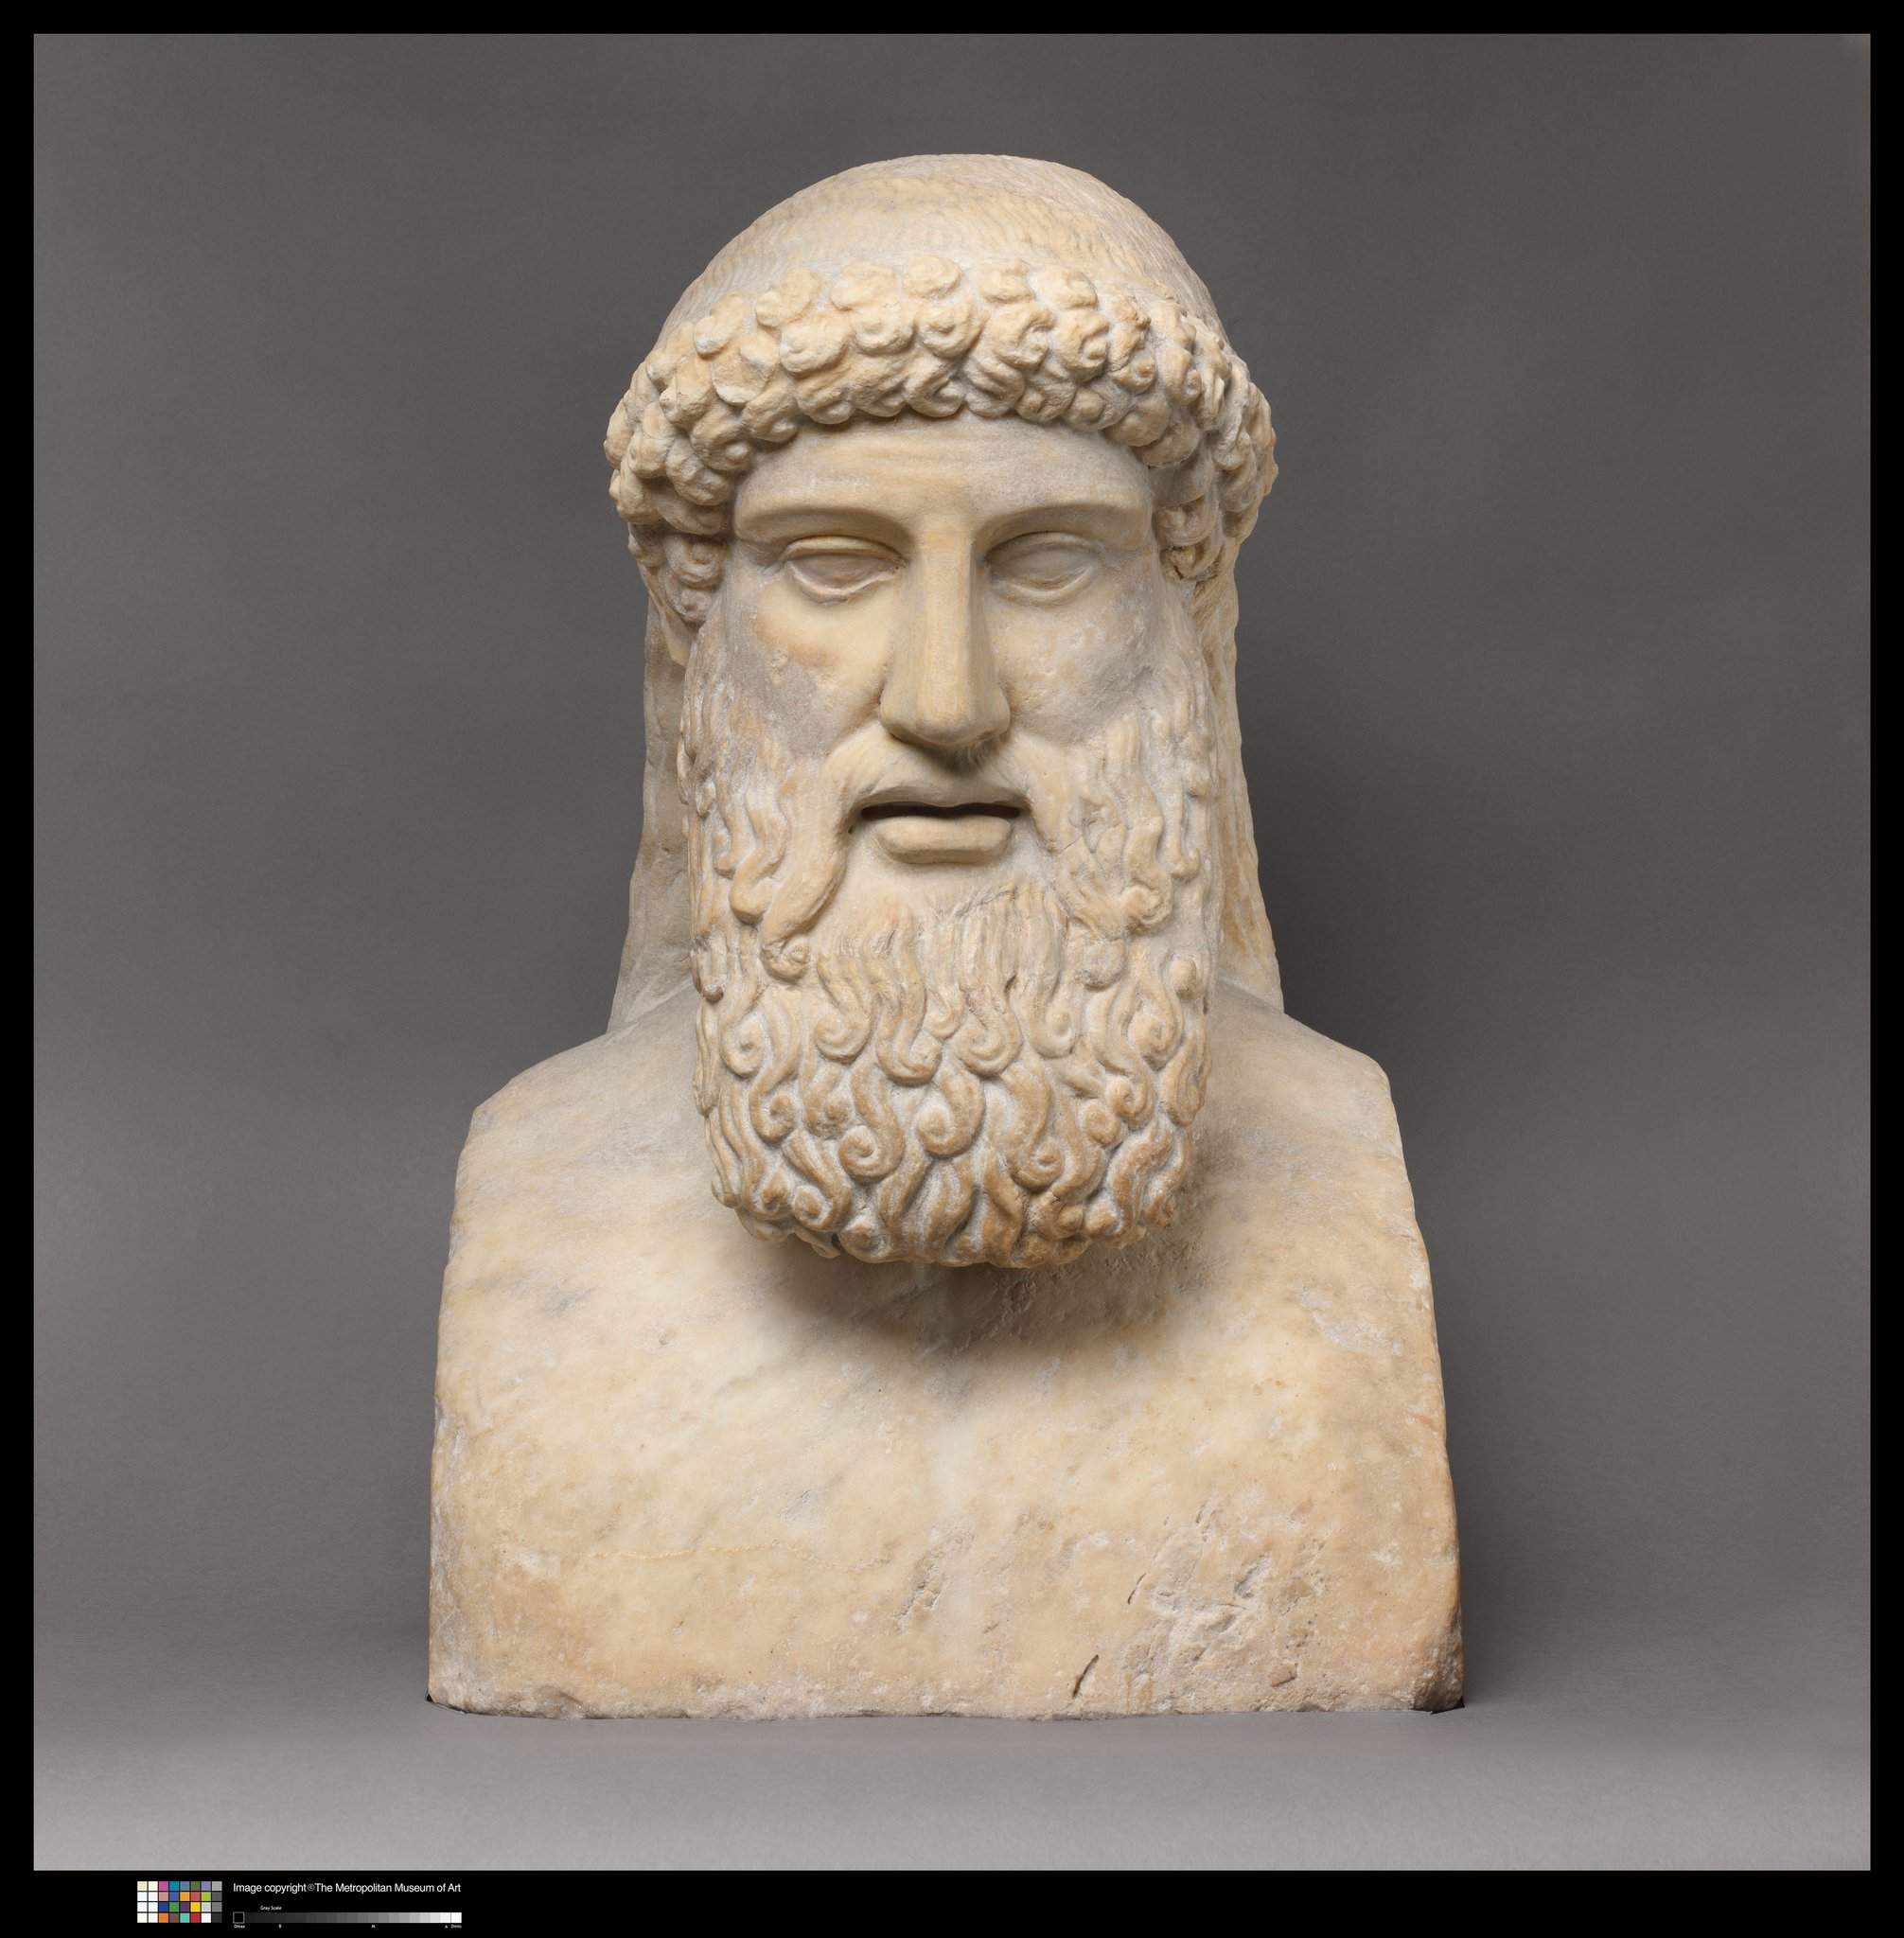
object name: herm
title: Marble herm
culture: roman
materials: marble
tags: men,hermes